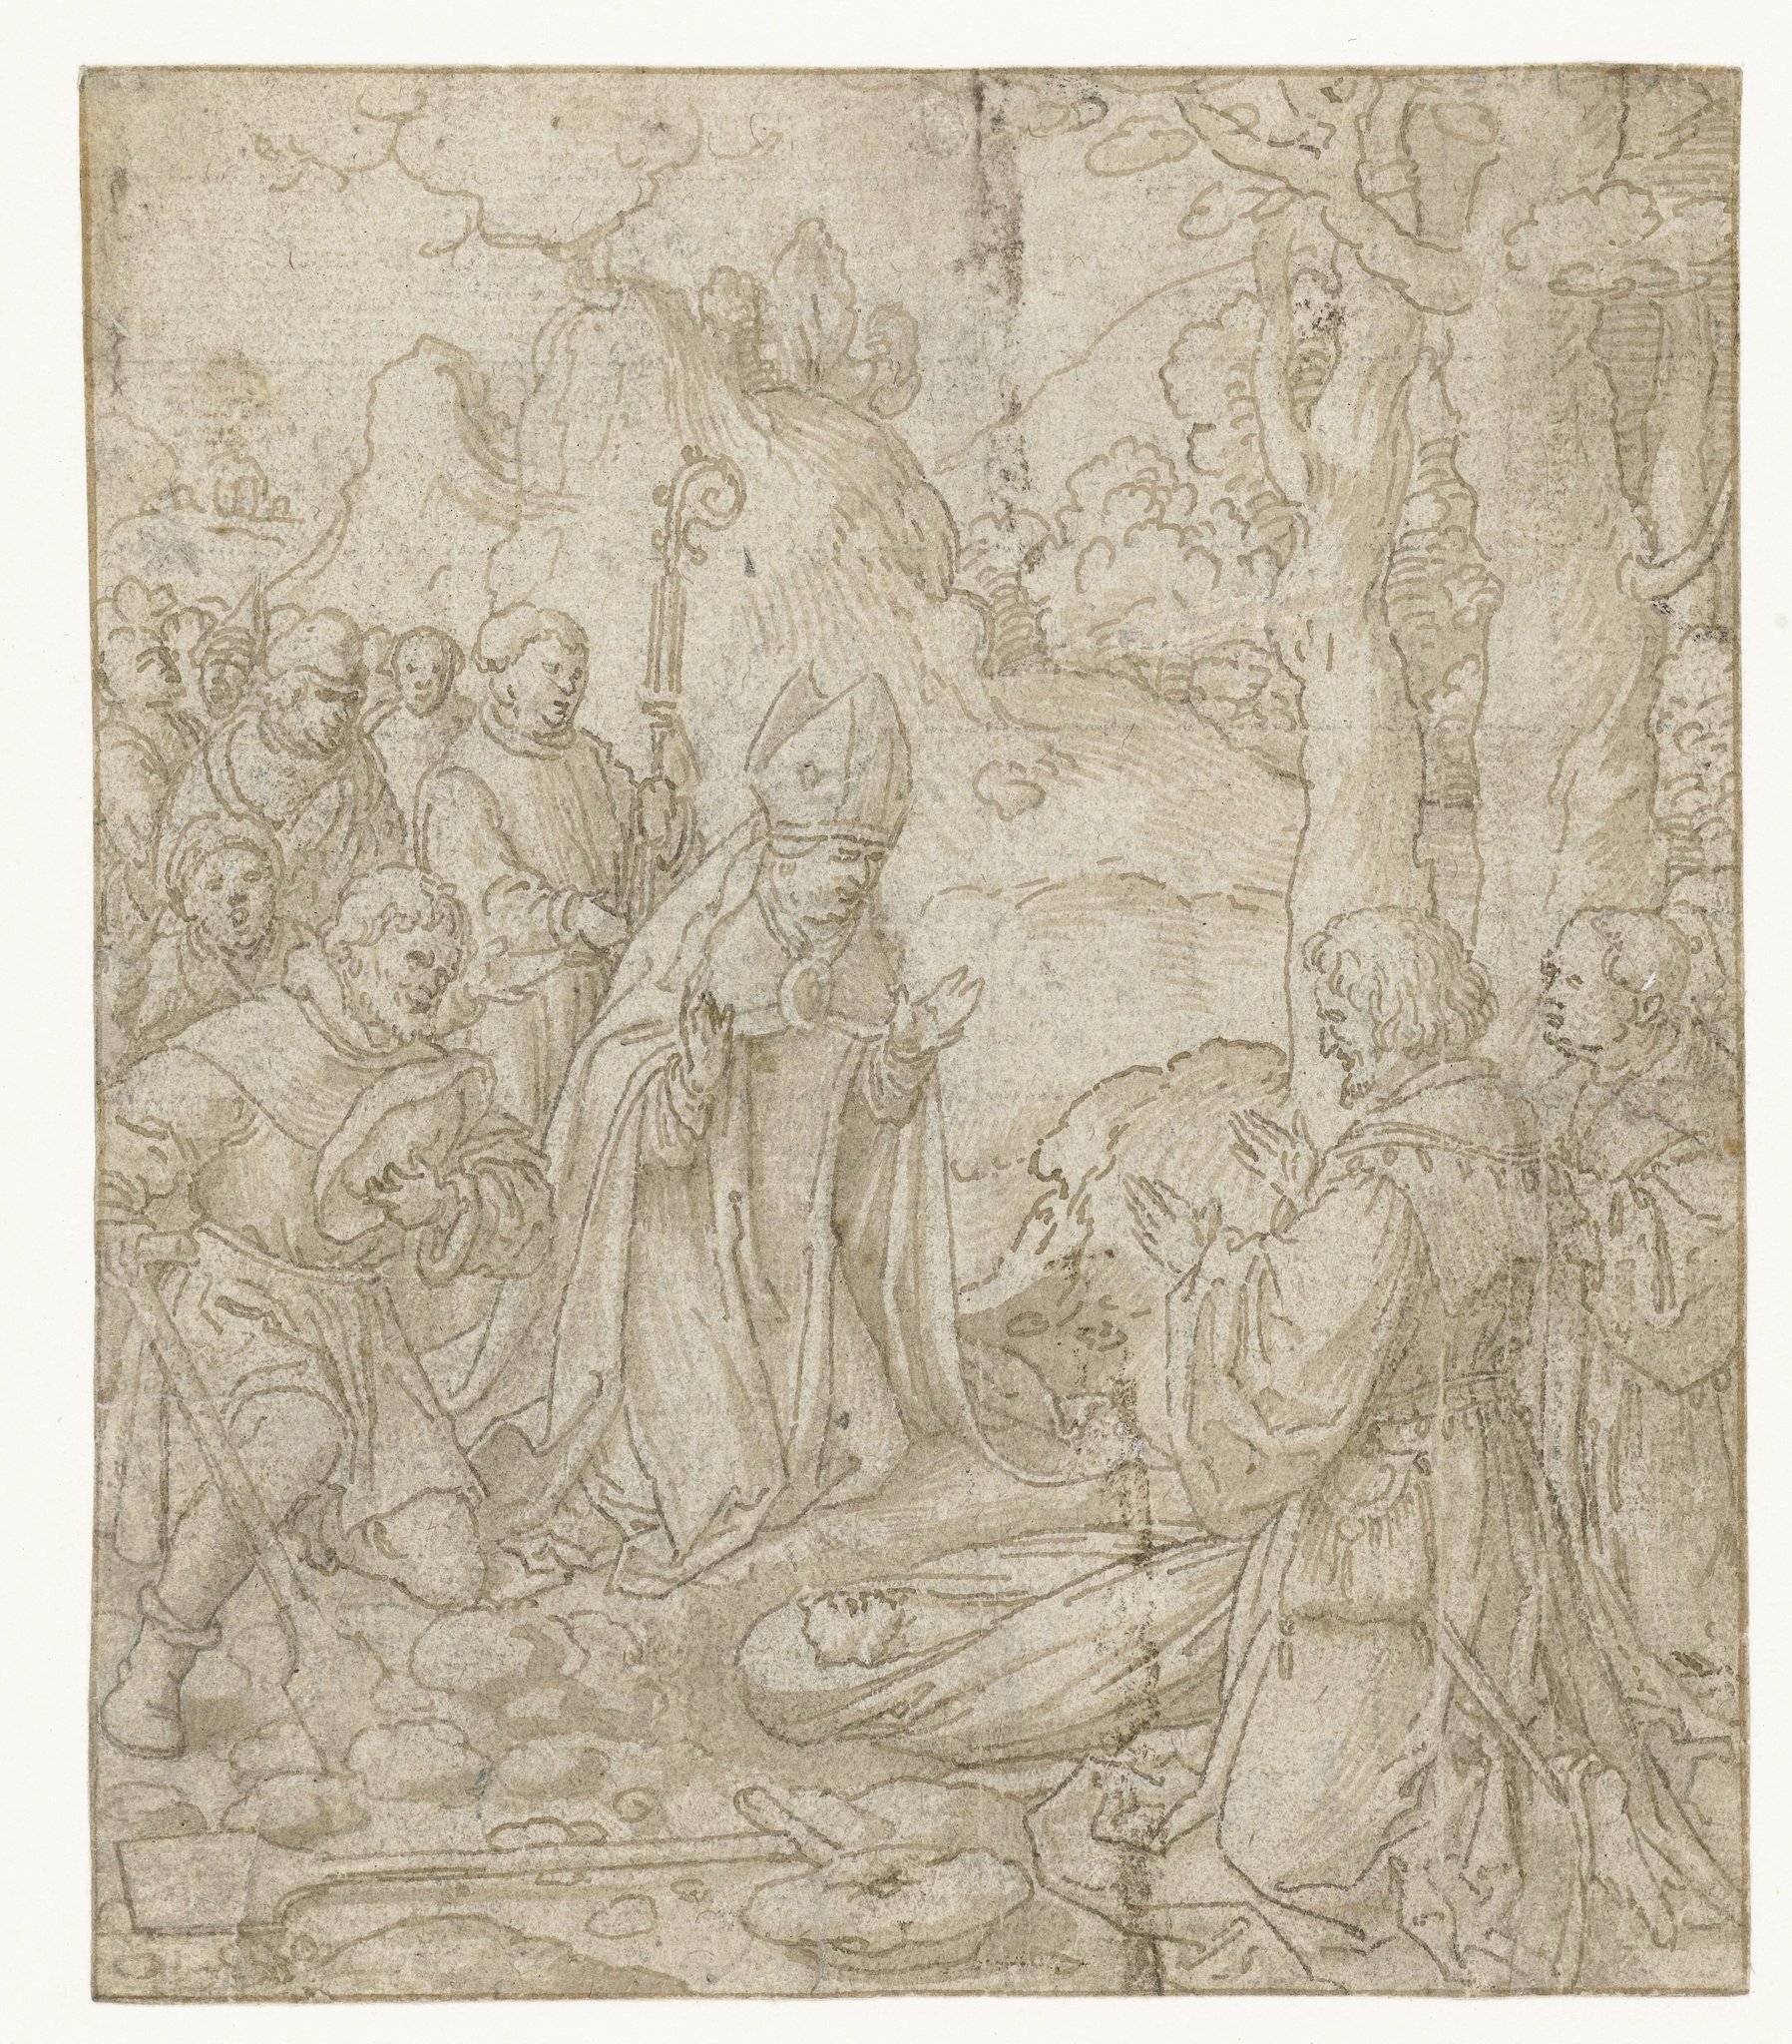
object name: drawing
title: Bisschop (de heilige Martinus?) wekt een man weer tot leven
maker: bernard van orley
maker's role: draughtsman, painter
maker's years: 1487-1542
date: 1498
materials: ink, paper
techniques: brush, pen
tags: archbishop, bishop, etc. (roman catholic), miraculous healings of st. martin